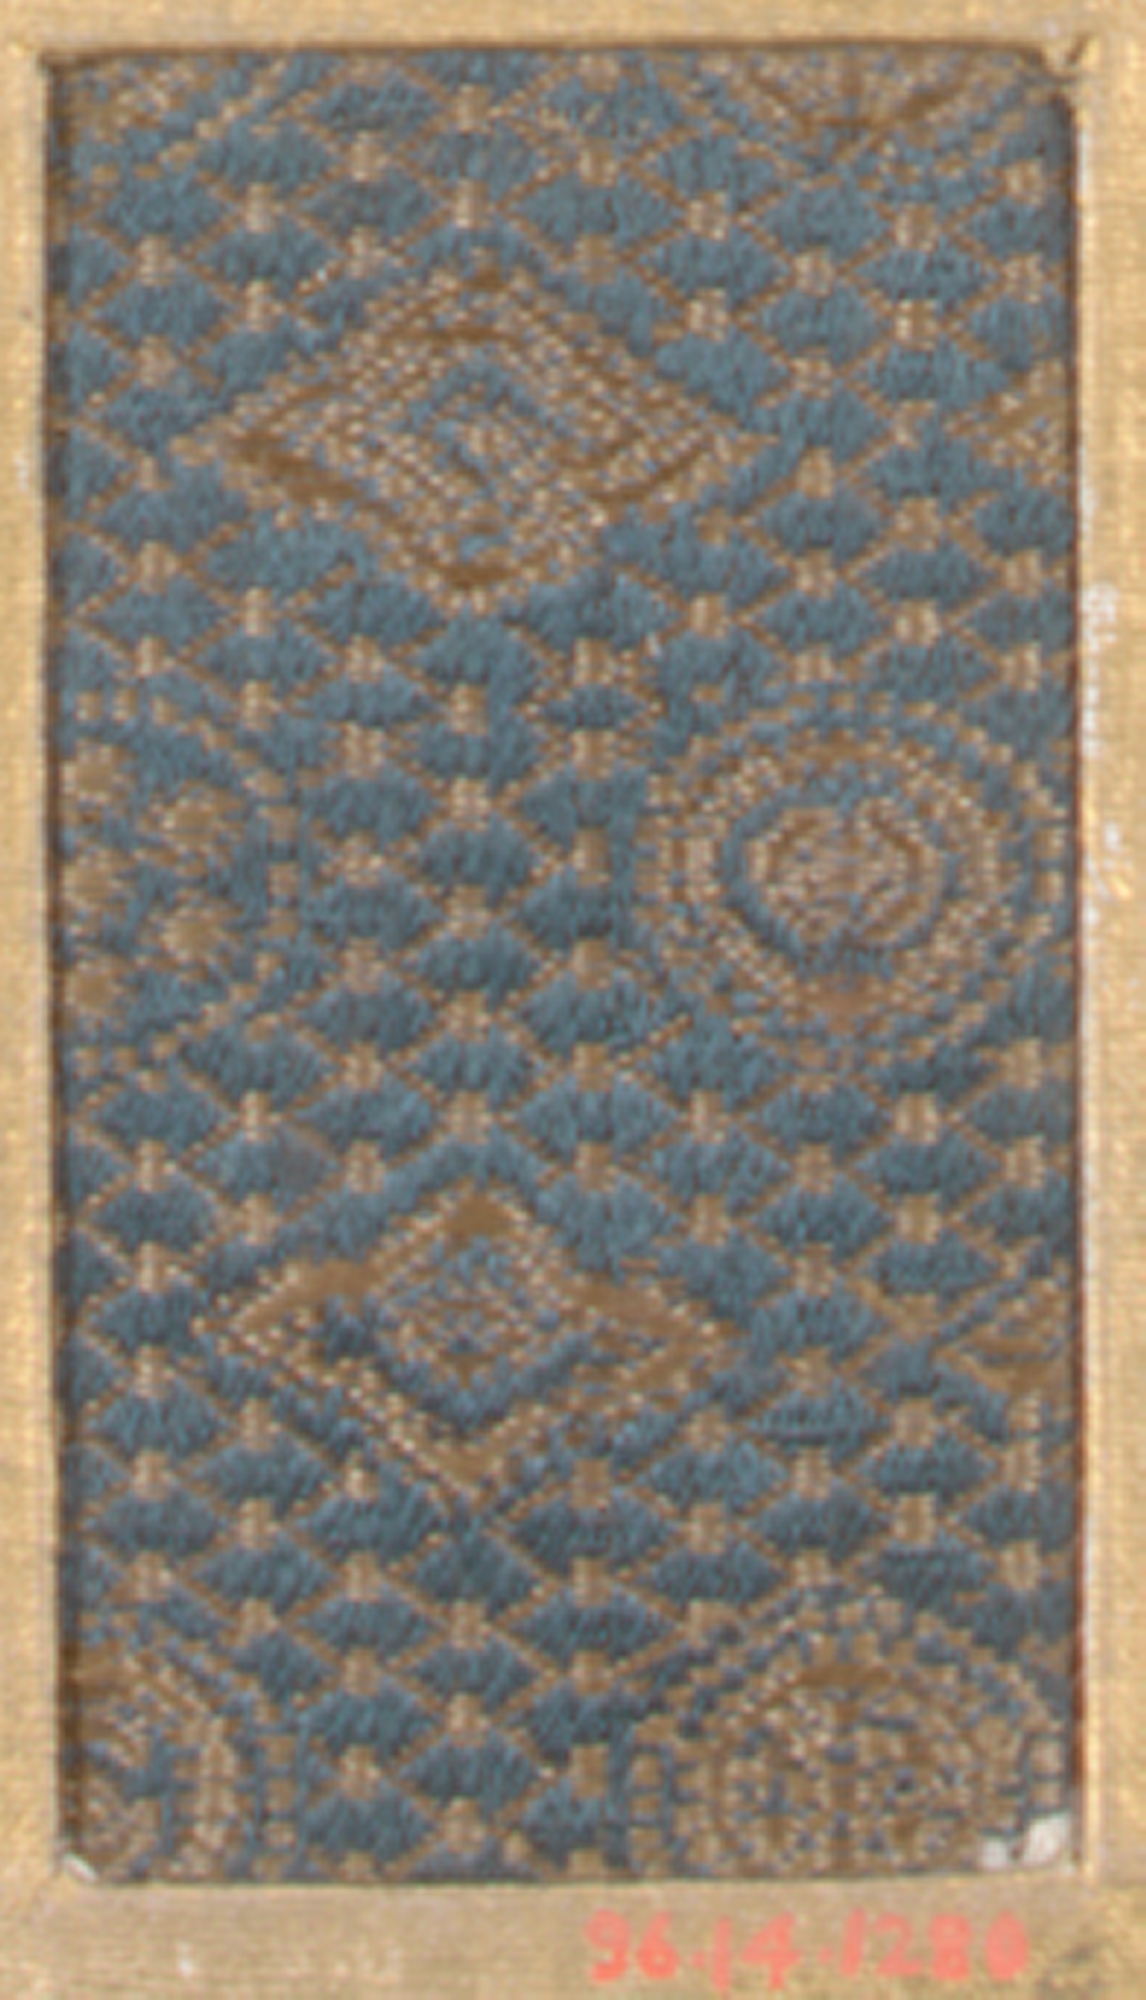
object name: piece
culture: japanese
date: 1701-1900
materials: silk